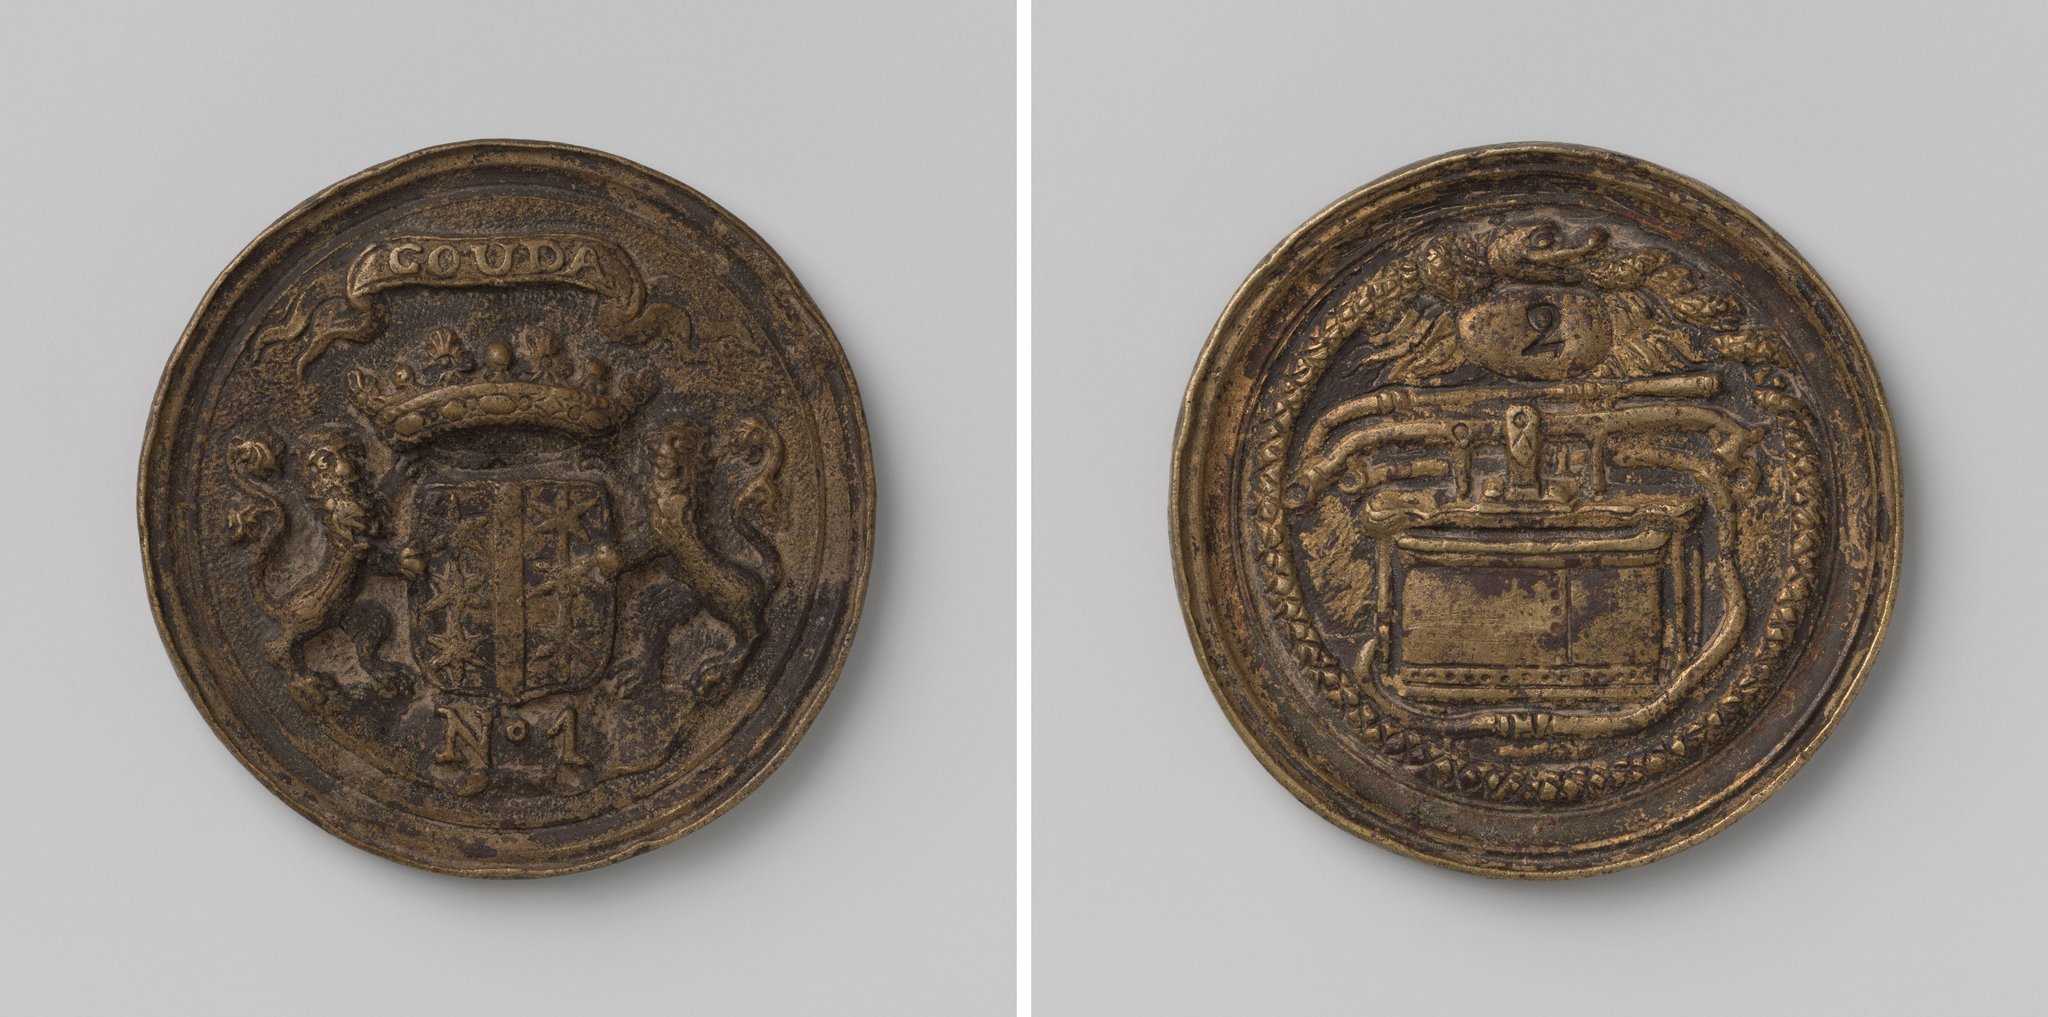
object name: fire engine medal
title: Gouda, brandspuitpenning van spuit 1 met no. 2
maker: Anonymous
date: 1690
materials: brass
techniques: casting, engraving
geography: gouda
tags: gouda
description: Messing penning. Voorzijde: gekroond wapenschild, geflankeerd door twee leeuwen onder lint met opschrift boven cijfer No. 1. Keerzijde: brandspuit onder cartouche met cijfer 2 binnen slangerond